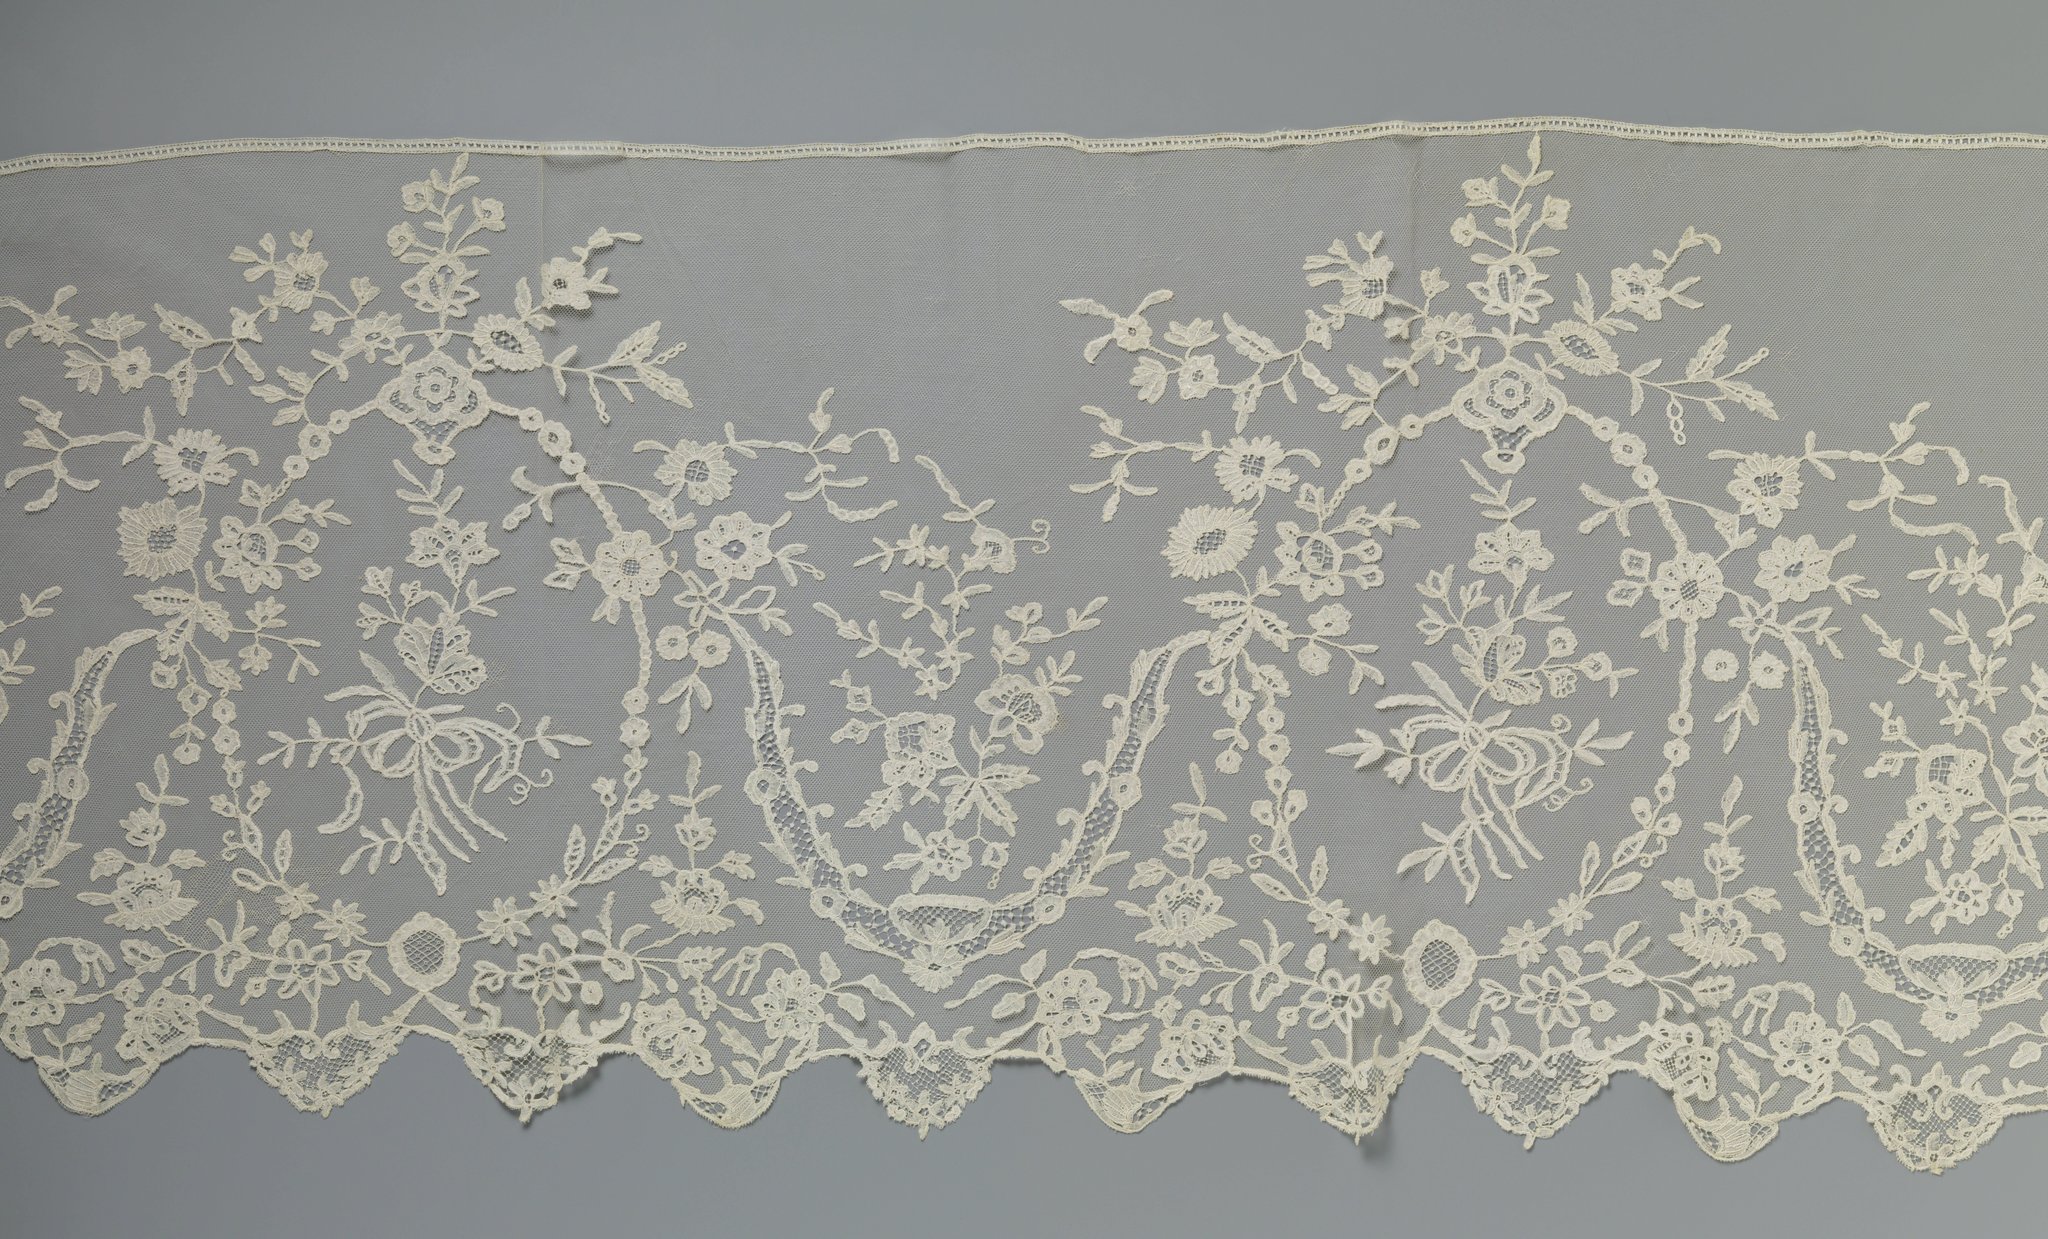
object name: strip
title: Japonstrook van applicatiekant met slinger en ovaal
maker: Anonymous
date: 1840-1849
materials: linen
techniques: lace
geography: brussels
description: Japonstrook van naturelkleurige applicatiekant, kloskant en naaldkant geappliceerd op machinale tule. Een dunne, ovale bloem- en bladslinger, asymmetrisch opgebouwd, maar met symmetrische medaillons in de top en aan de voet, wisselt af met een diep doorbuigende slinger met rasterwerkvulling. Binnen het ovaal staat een gestrikt boeket, boven de slinger een enkele bloemtak. Uitsluitend het fond boven het ovaal is gevuld met bloemtakken. Diepe, driezijdige schulpen met een symmetrische reserve met rastervulling worden, onder de slinger, geflankeerd door reserves met kuifvormig blad. De strook bestaat uit twee delen die rondlopend aan elkaar zijn gezet.